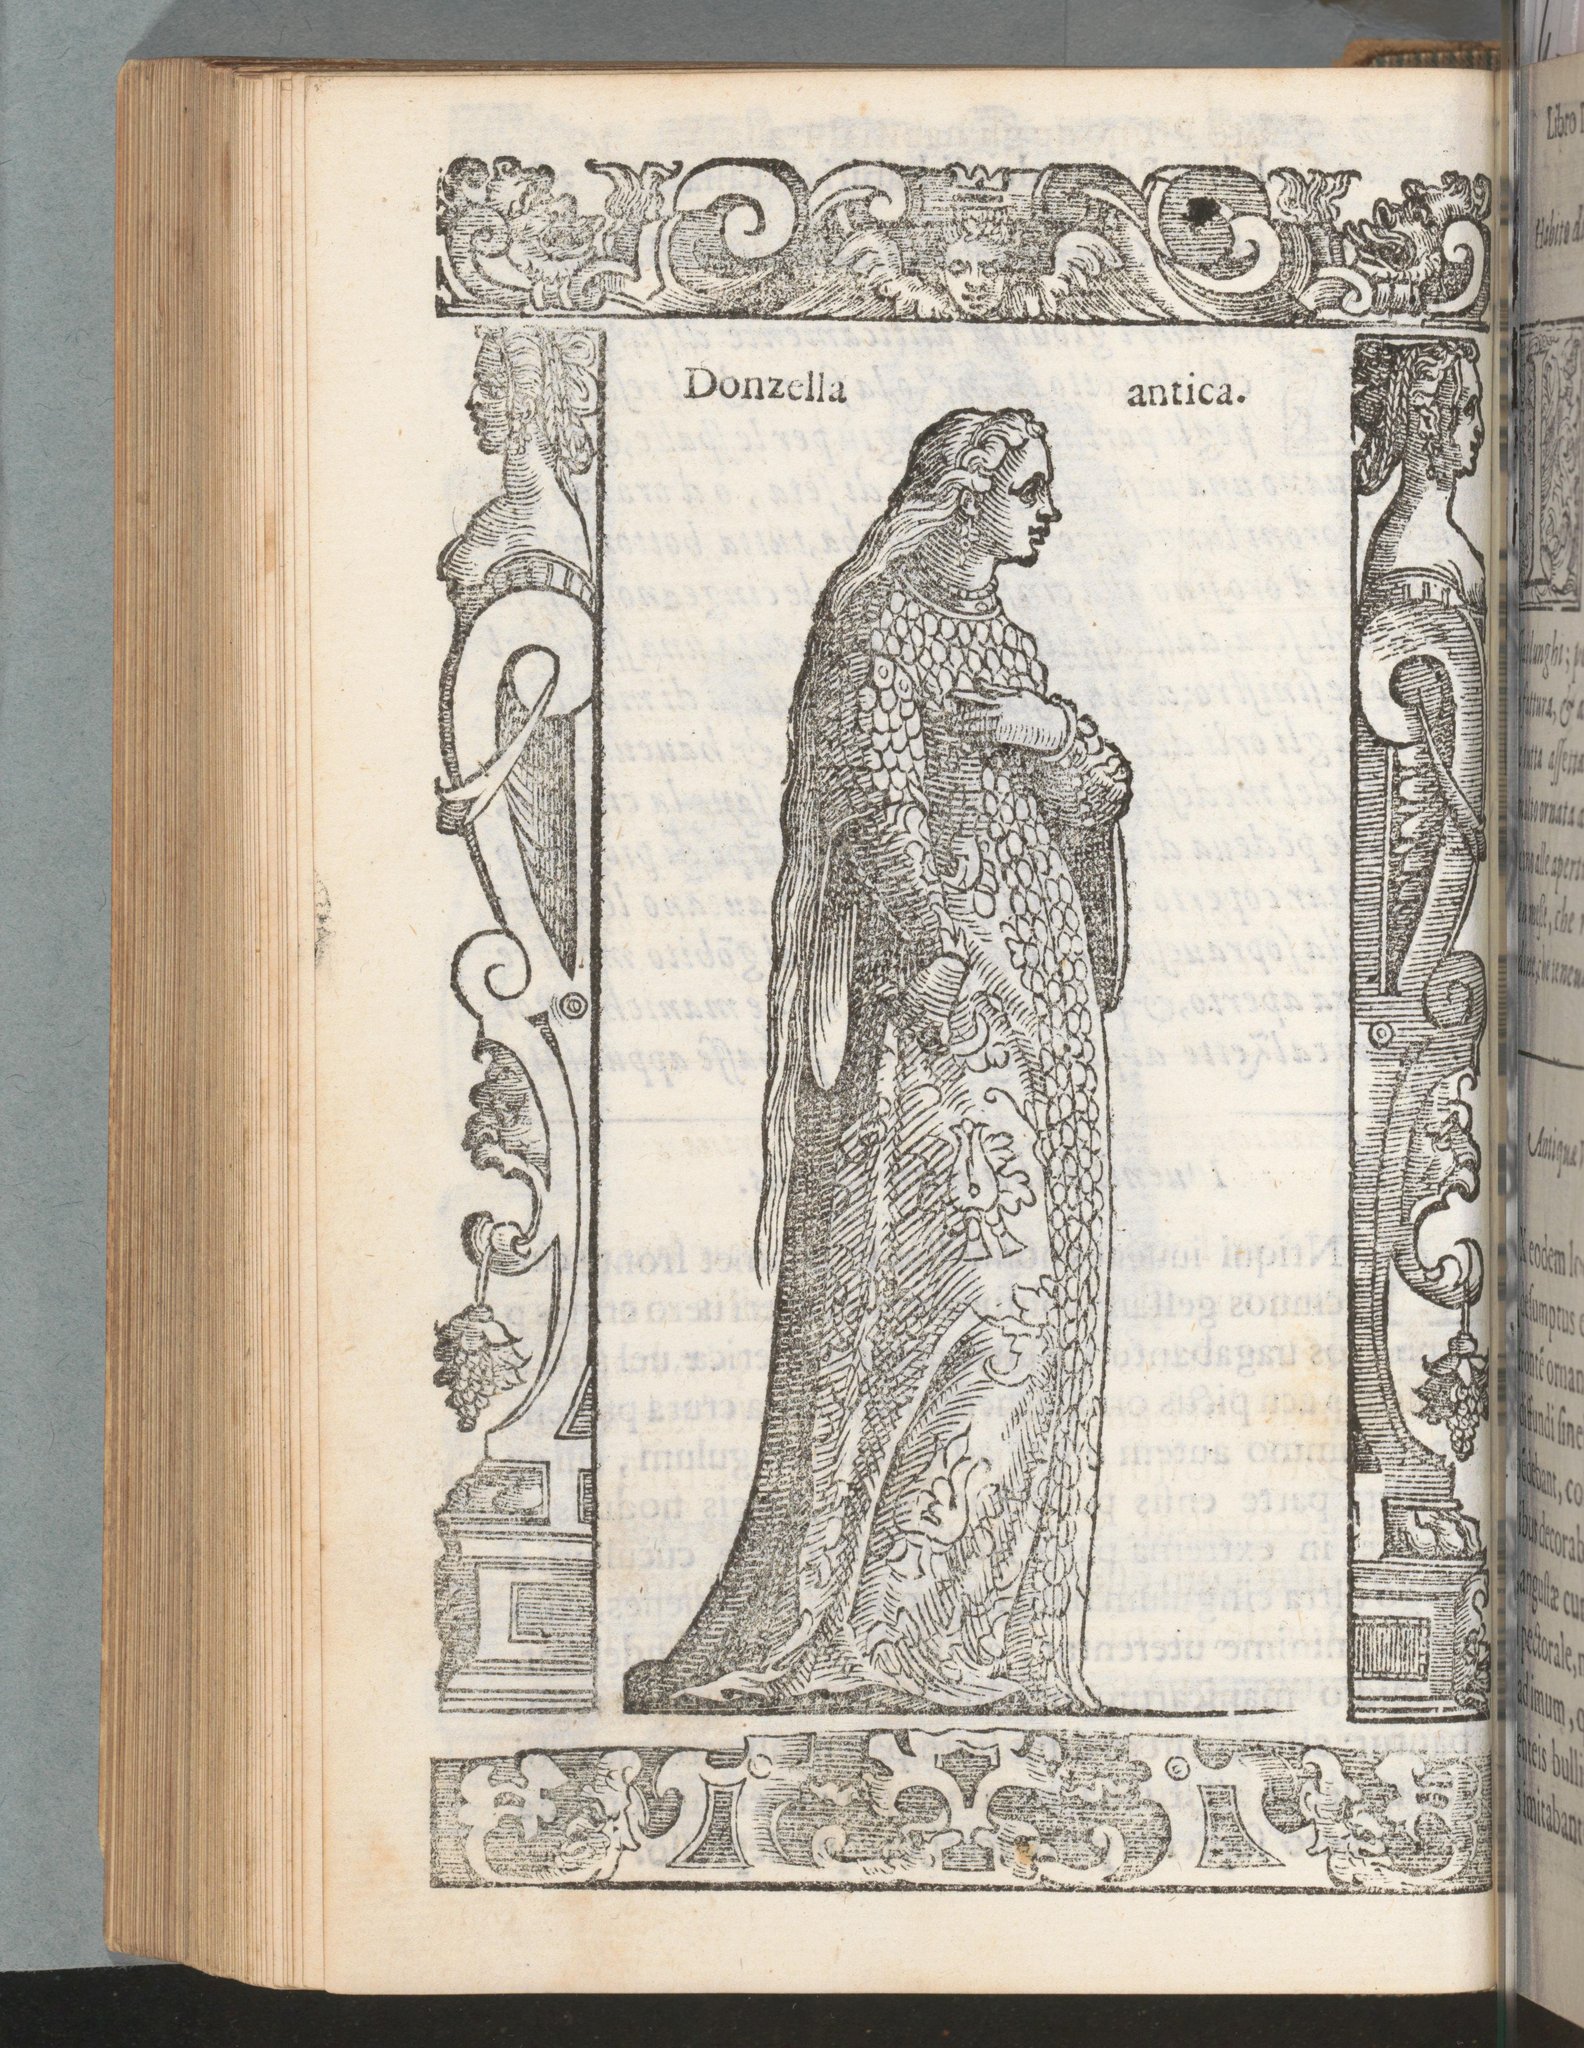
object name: costume print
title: Habiti antichi, et moderni di tutto il mondo..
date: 1598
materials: paper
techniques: woodcut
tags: fashion plates